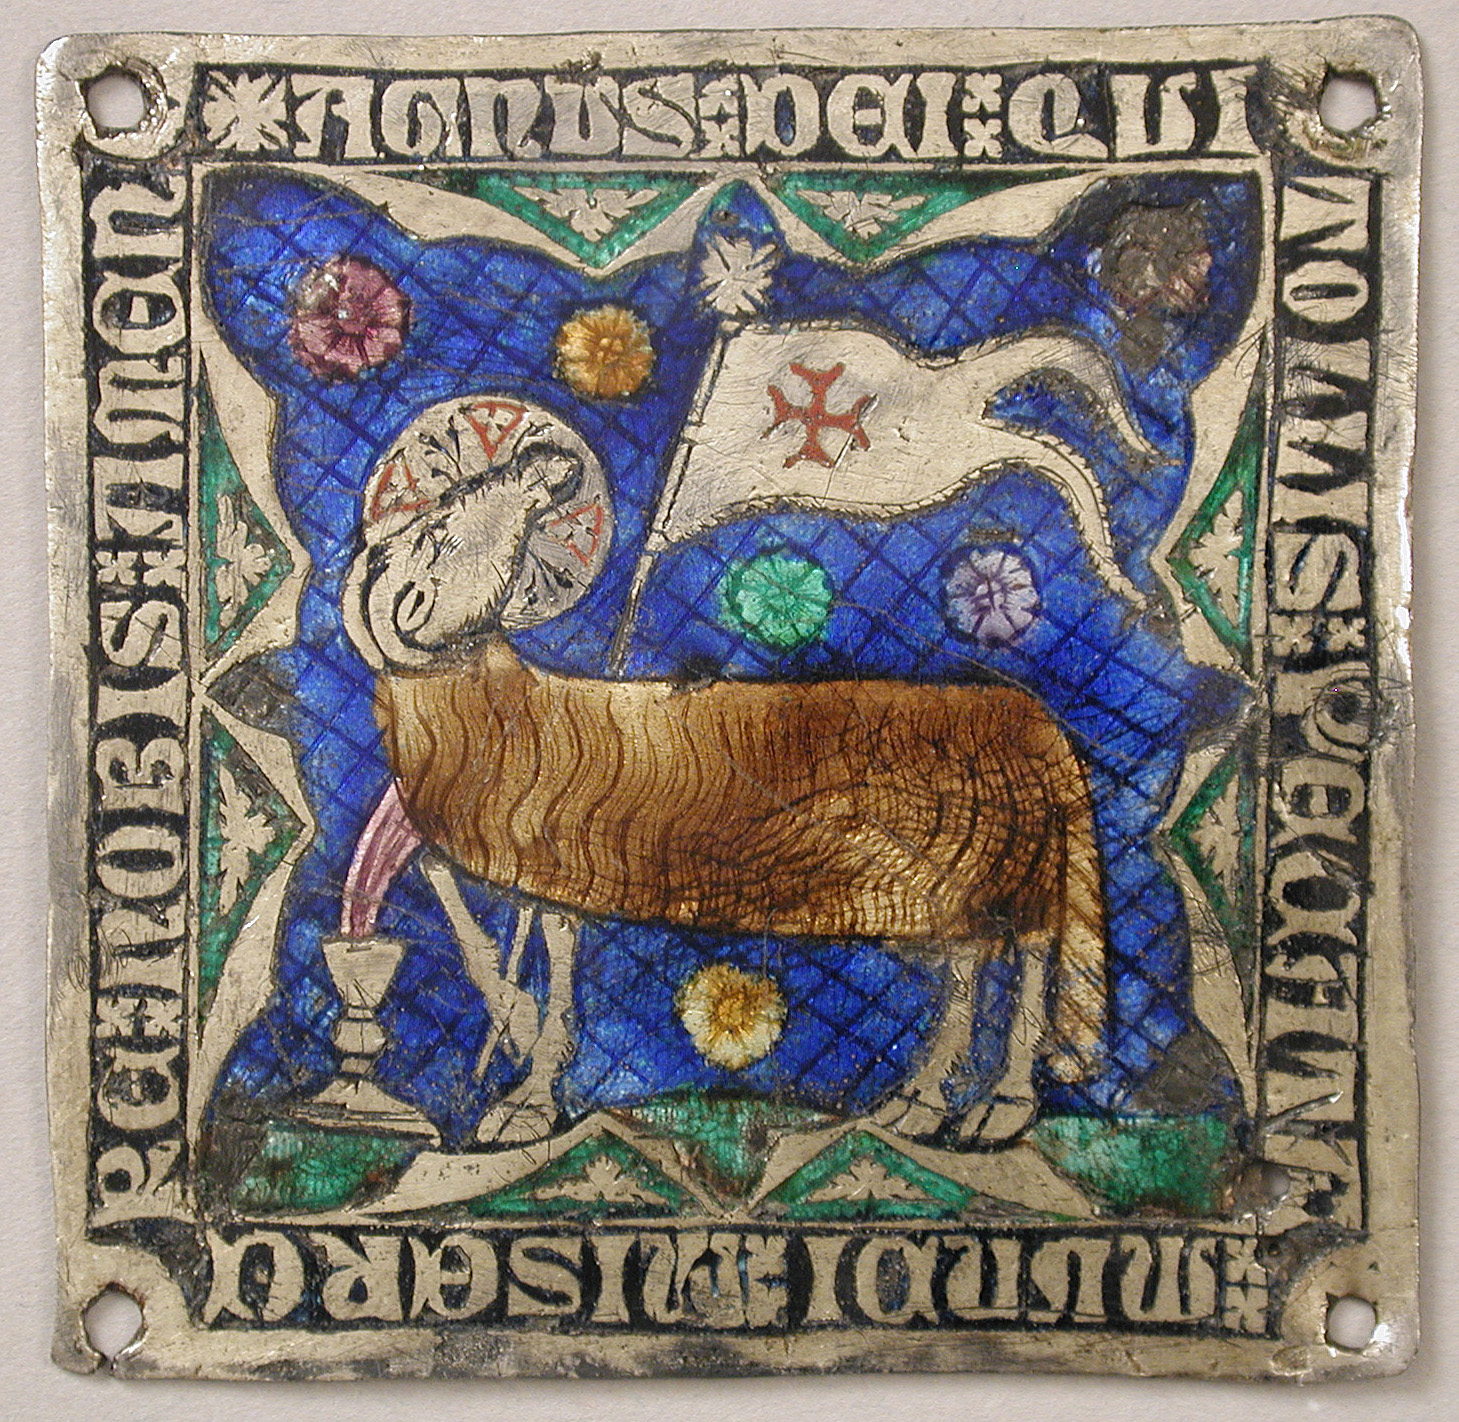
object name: plaque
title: Plaque with Agnus Dei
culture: catalan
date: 1301-1400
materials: enamel, silver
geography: spain